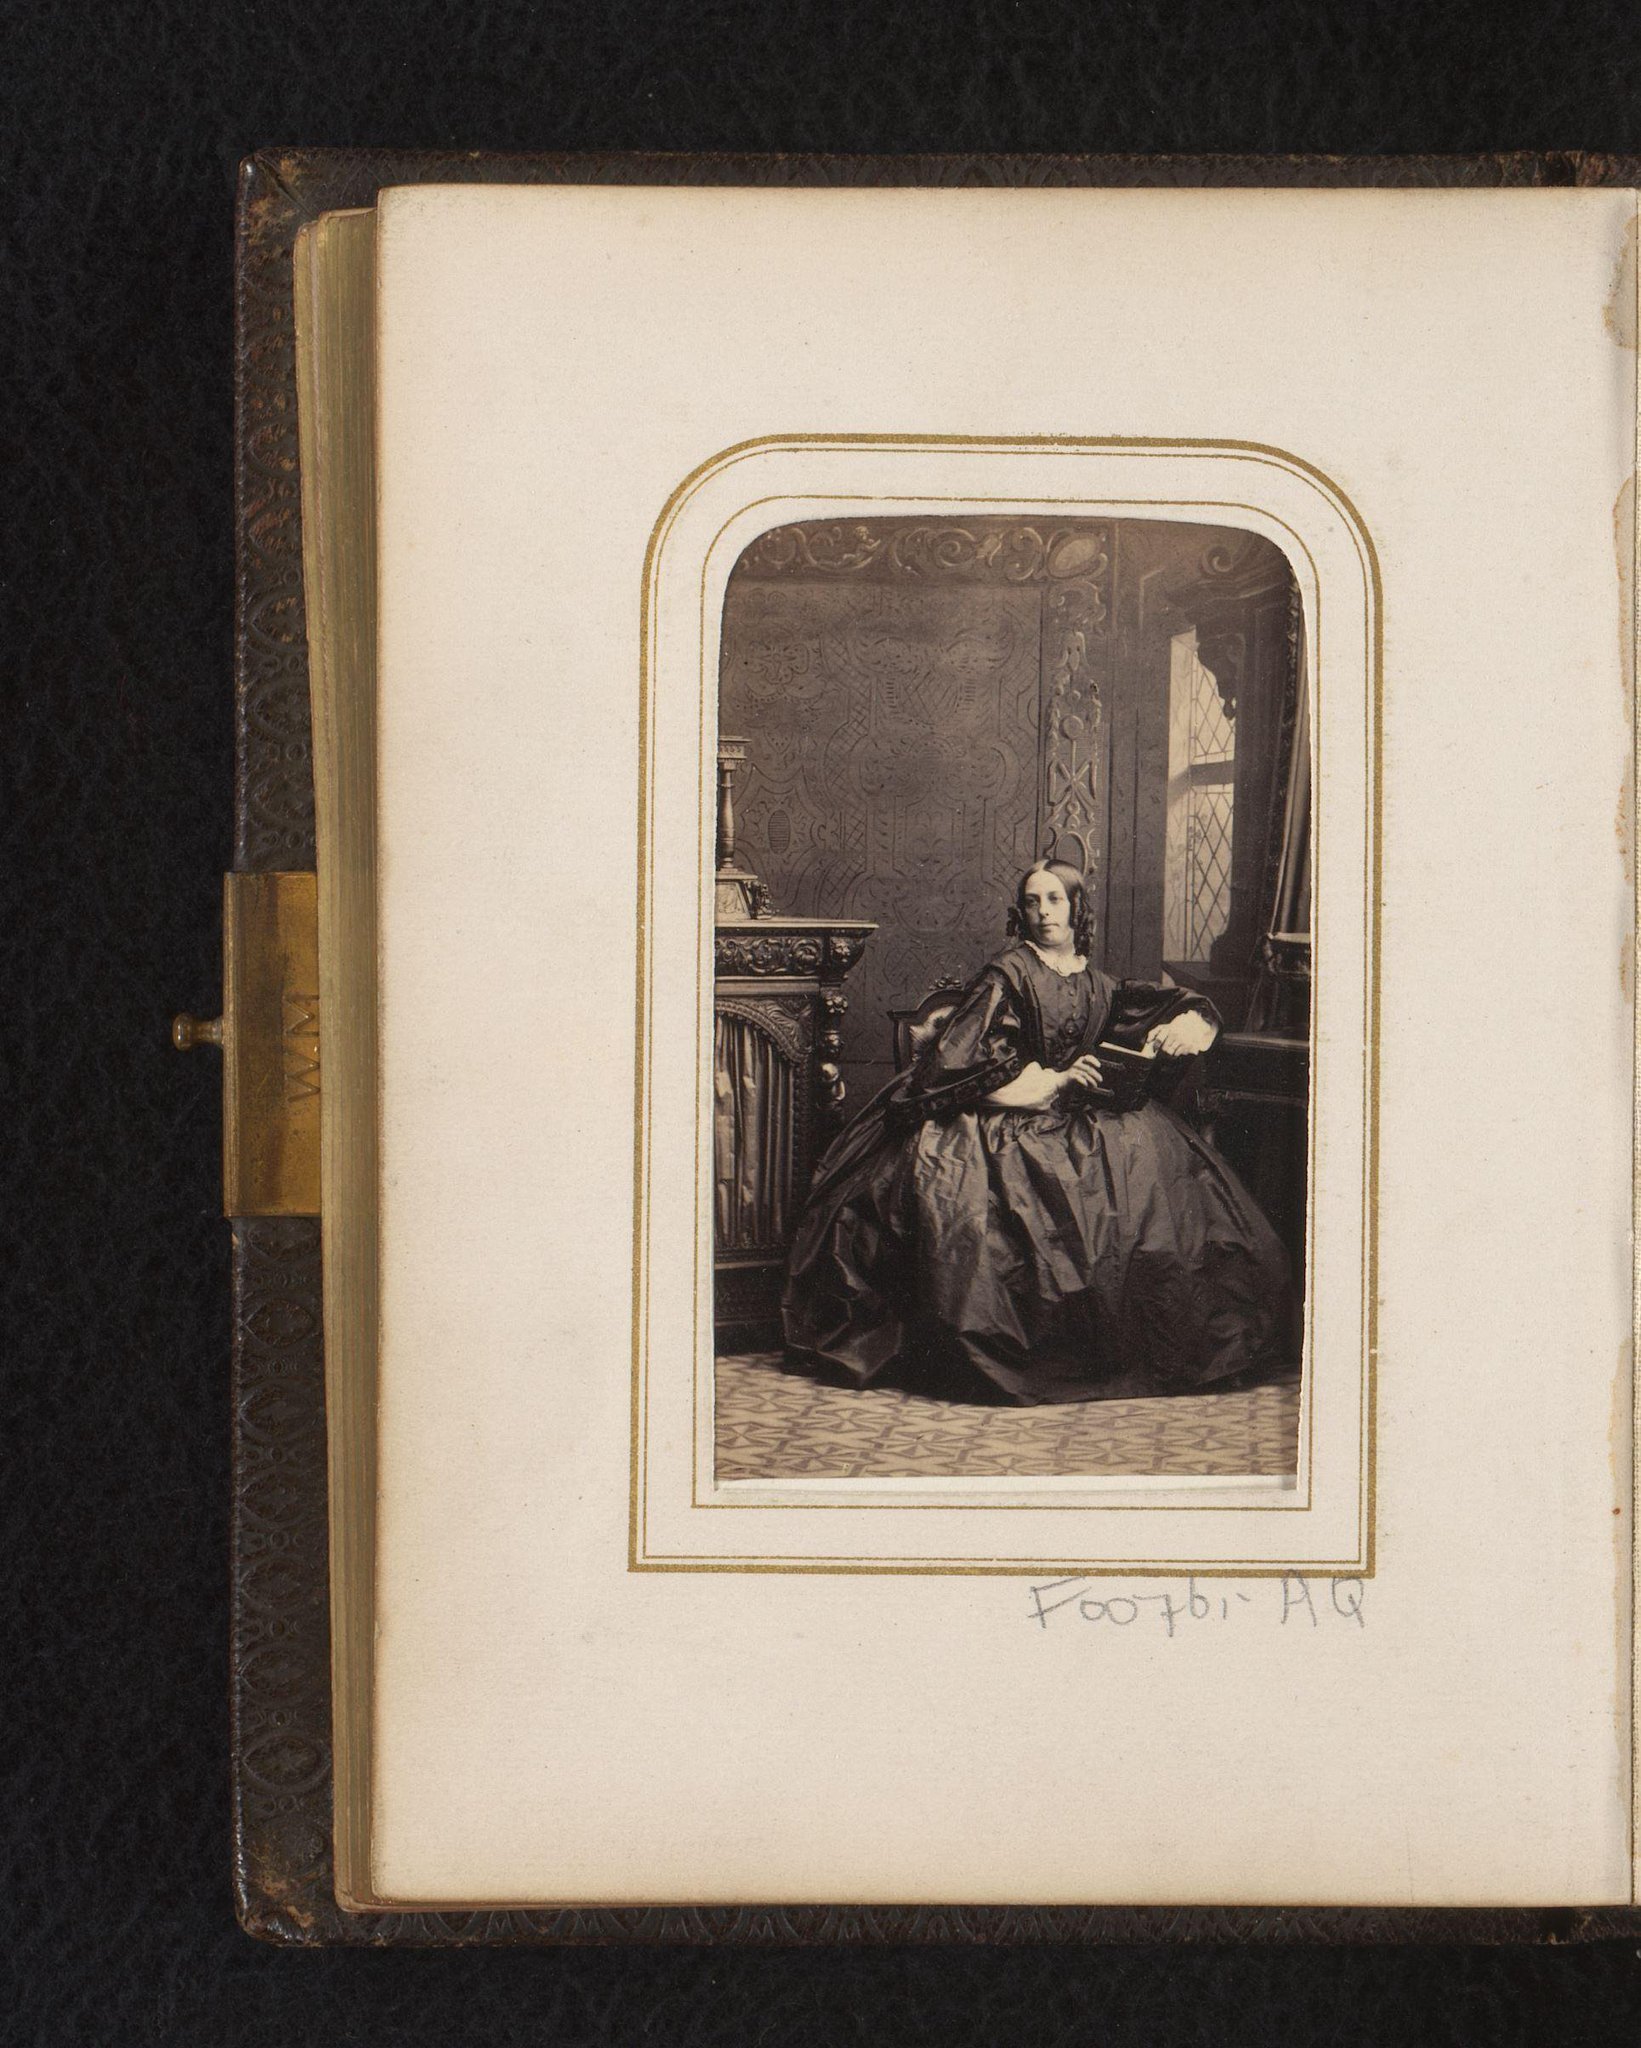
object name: album leaf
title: Portret van een zittende vrouw met boek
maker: camille leon louis silvy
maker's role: fotograaf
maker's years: 1834-1910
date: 1859-1890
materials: cardboard, photographic support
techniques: albumen print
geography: london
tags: historical persons - bb - woman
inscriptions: inscription: ‘C. Silvy/ 38 Porchester Terrace/ Bayswater W.’